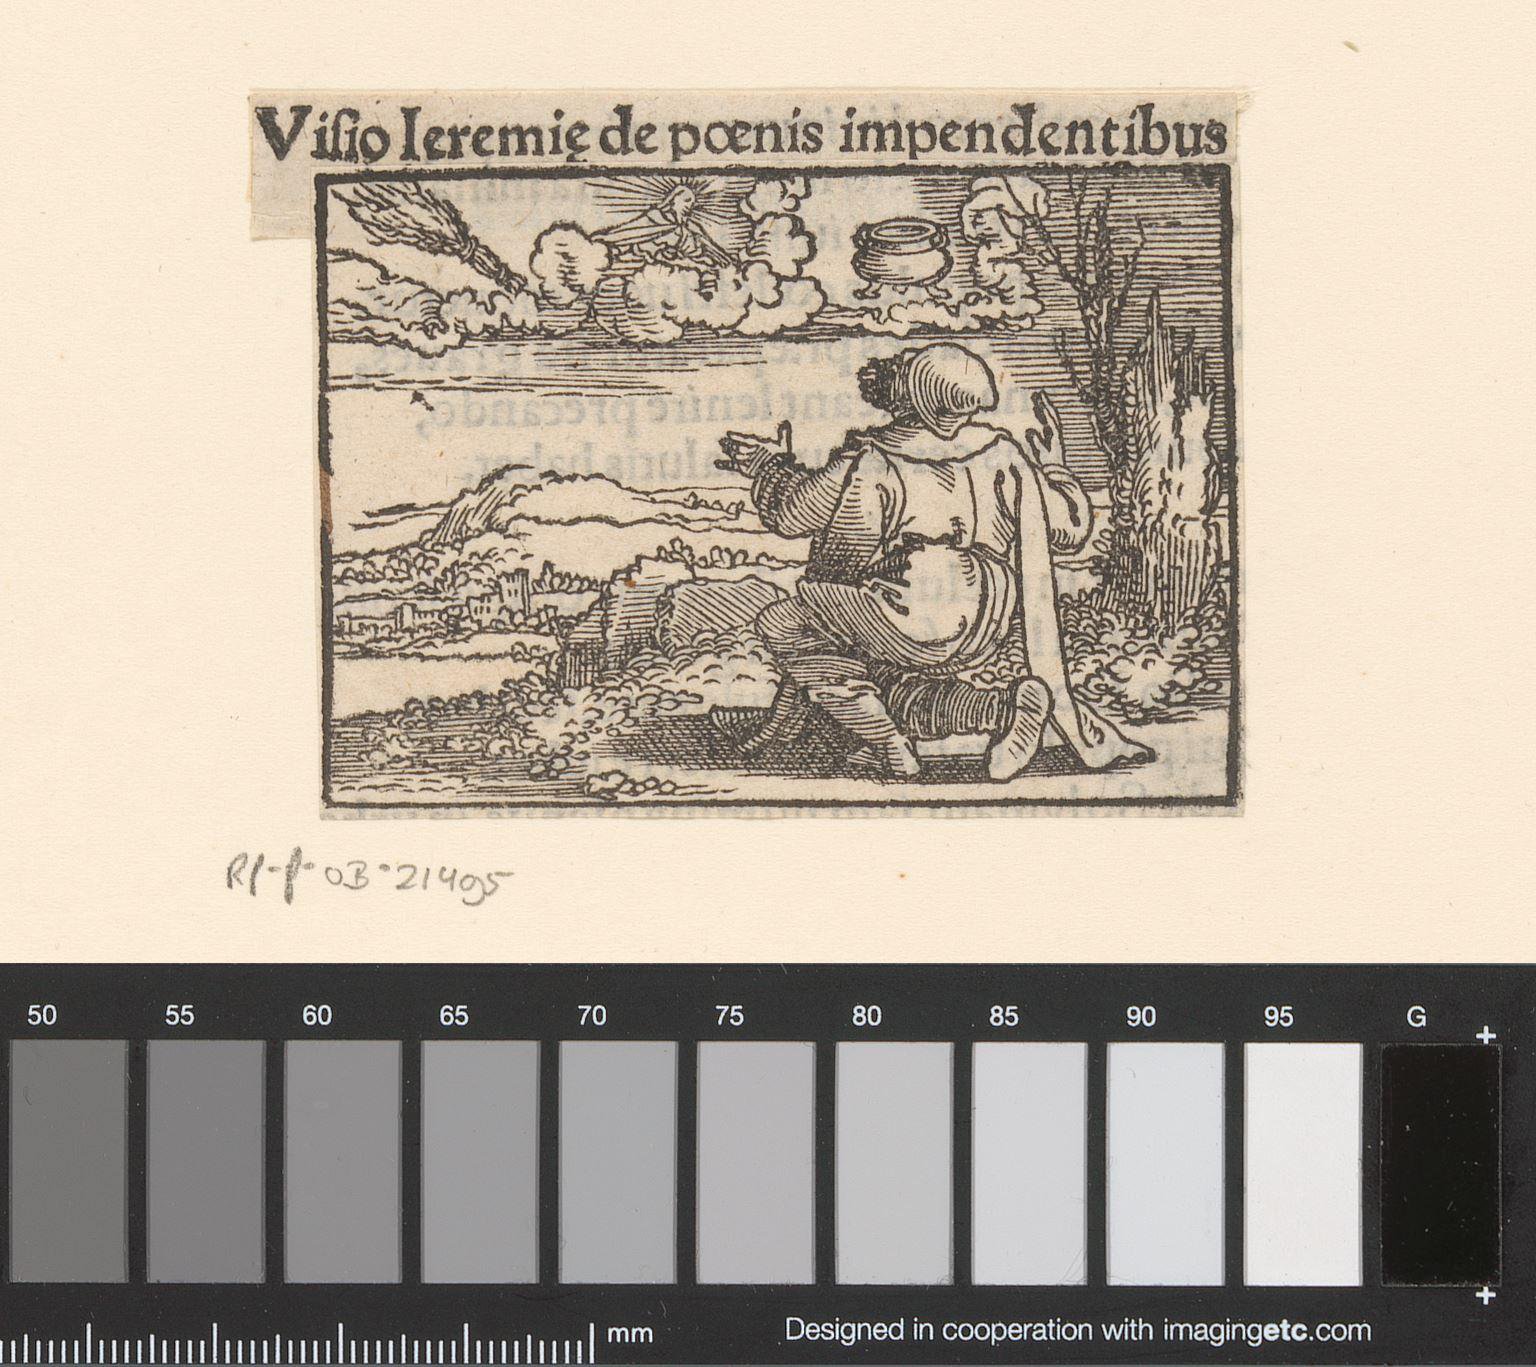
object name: book illustration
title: Visio Ieremie de poenis impendentibus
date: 1530-1533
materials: paper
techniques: woodcut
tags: jeremiah prophesying the destruction of jerusalem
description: Prent afkomstig uit: Biblicae historiae. Frankfurt am Main: Egenloph, 1539.